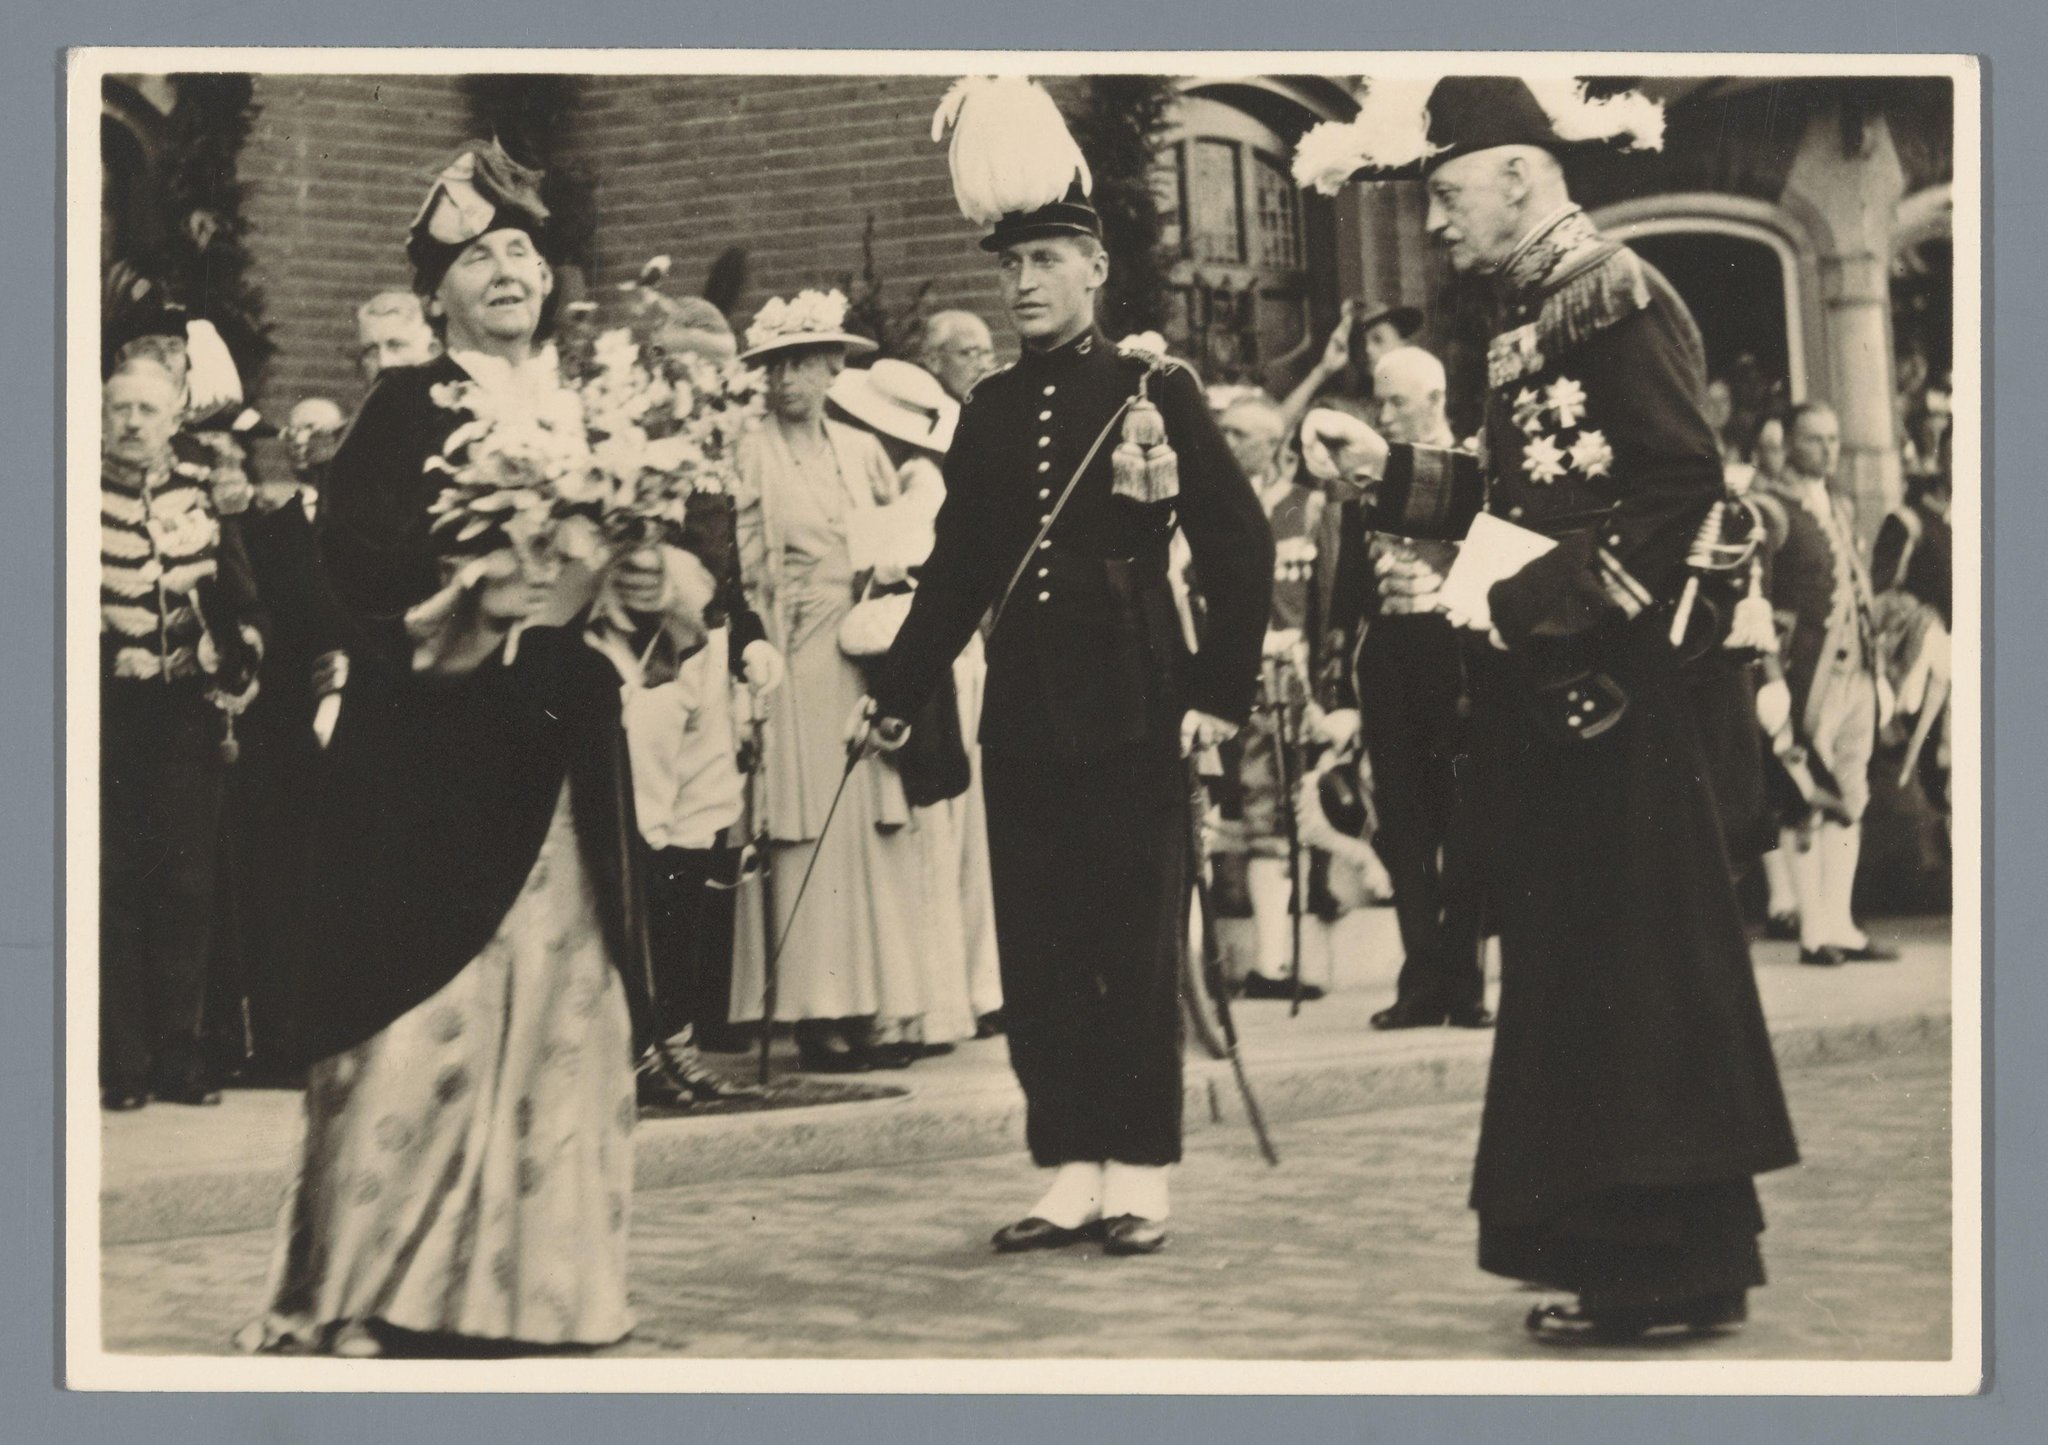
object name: ansichtkaart, prentbriefkaart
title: 40- jarig regeeringsjubileum van H.M. de koningin, Amsterdam, 5 September 1938, aankomst aan het Haarlemmermeerstation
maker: Anonymous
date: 1938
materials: photographic support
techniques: gelatin silver print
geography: haarlemmermeer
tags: the hague, print maker, wilhelmina of the netherlands, queen